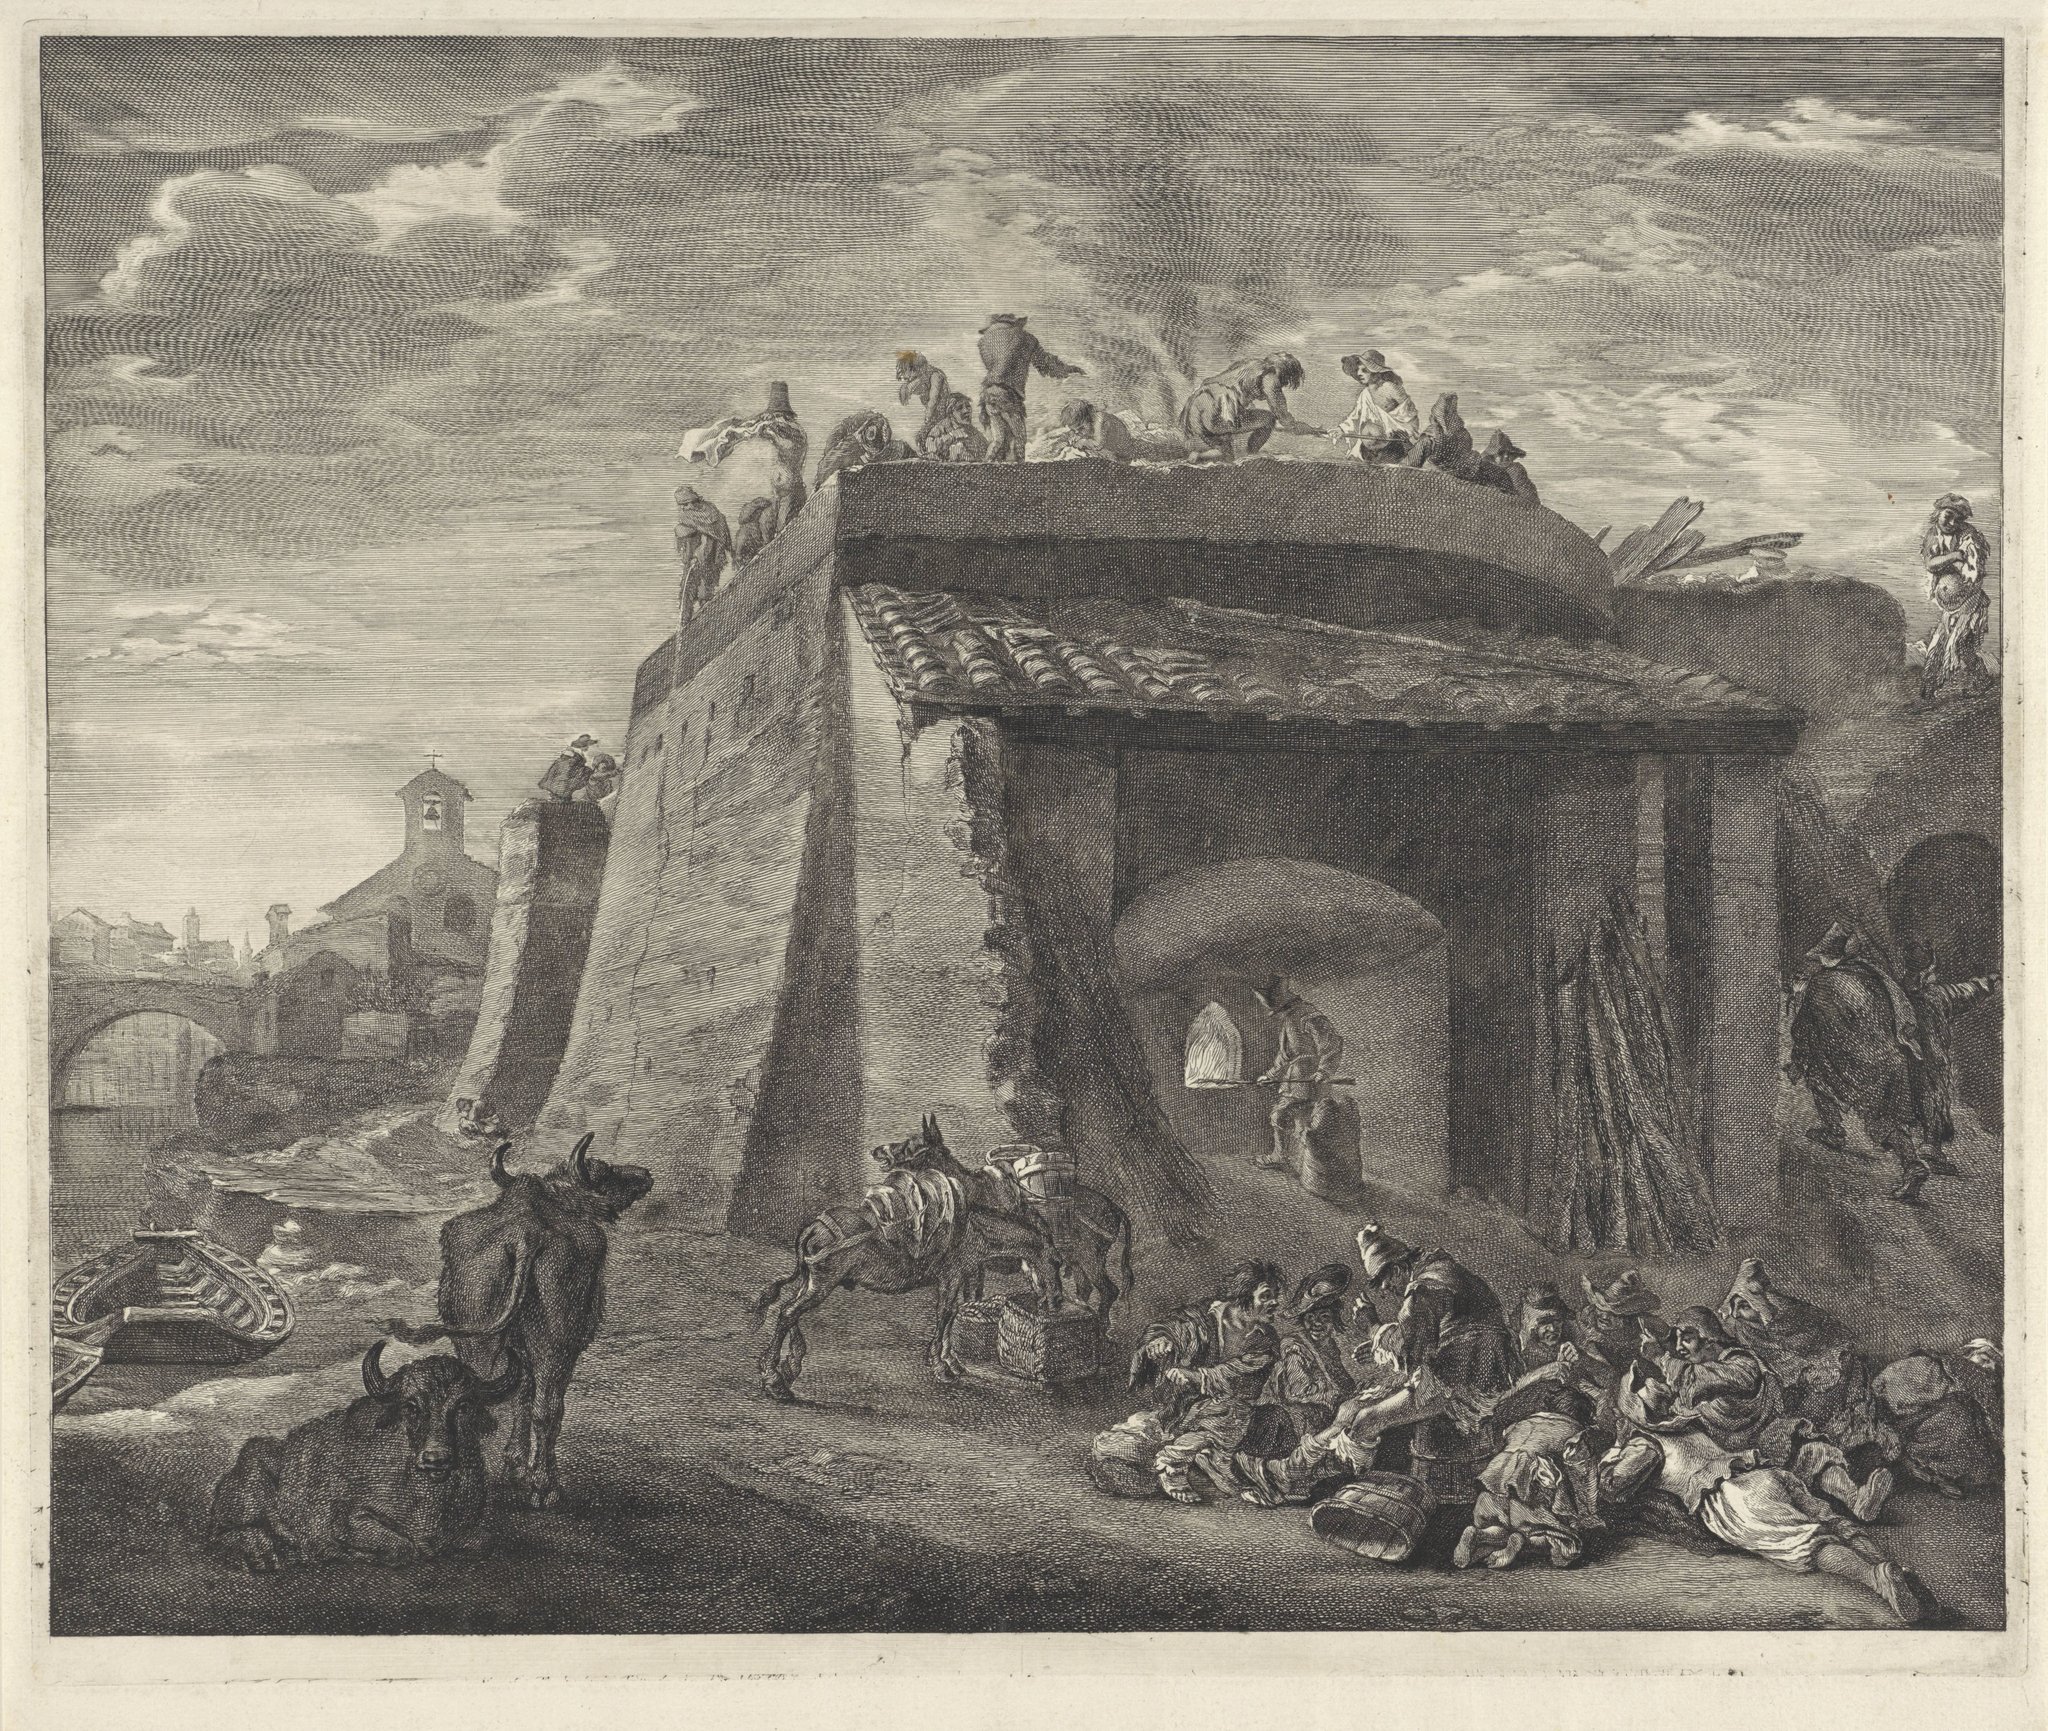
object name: print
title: Grote kalkoven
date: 1638-1658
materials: paper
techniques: etching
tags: cow, river, church (exterior), lime works, eating, resting - bb - out of doors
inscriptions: collector's mark: Lugt 240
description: Werklieden zijn hard aan het werk bij een grote kalkoven, die aan de rand van een rivier staat. Voor de oven pauzeert een groep arbeiders; ze eten en voeren gesprekken. Aan de waterkant twee koeien en twee boten. Op de achtergrond een kerk, een brug en vele woningen.